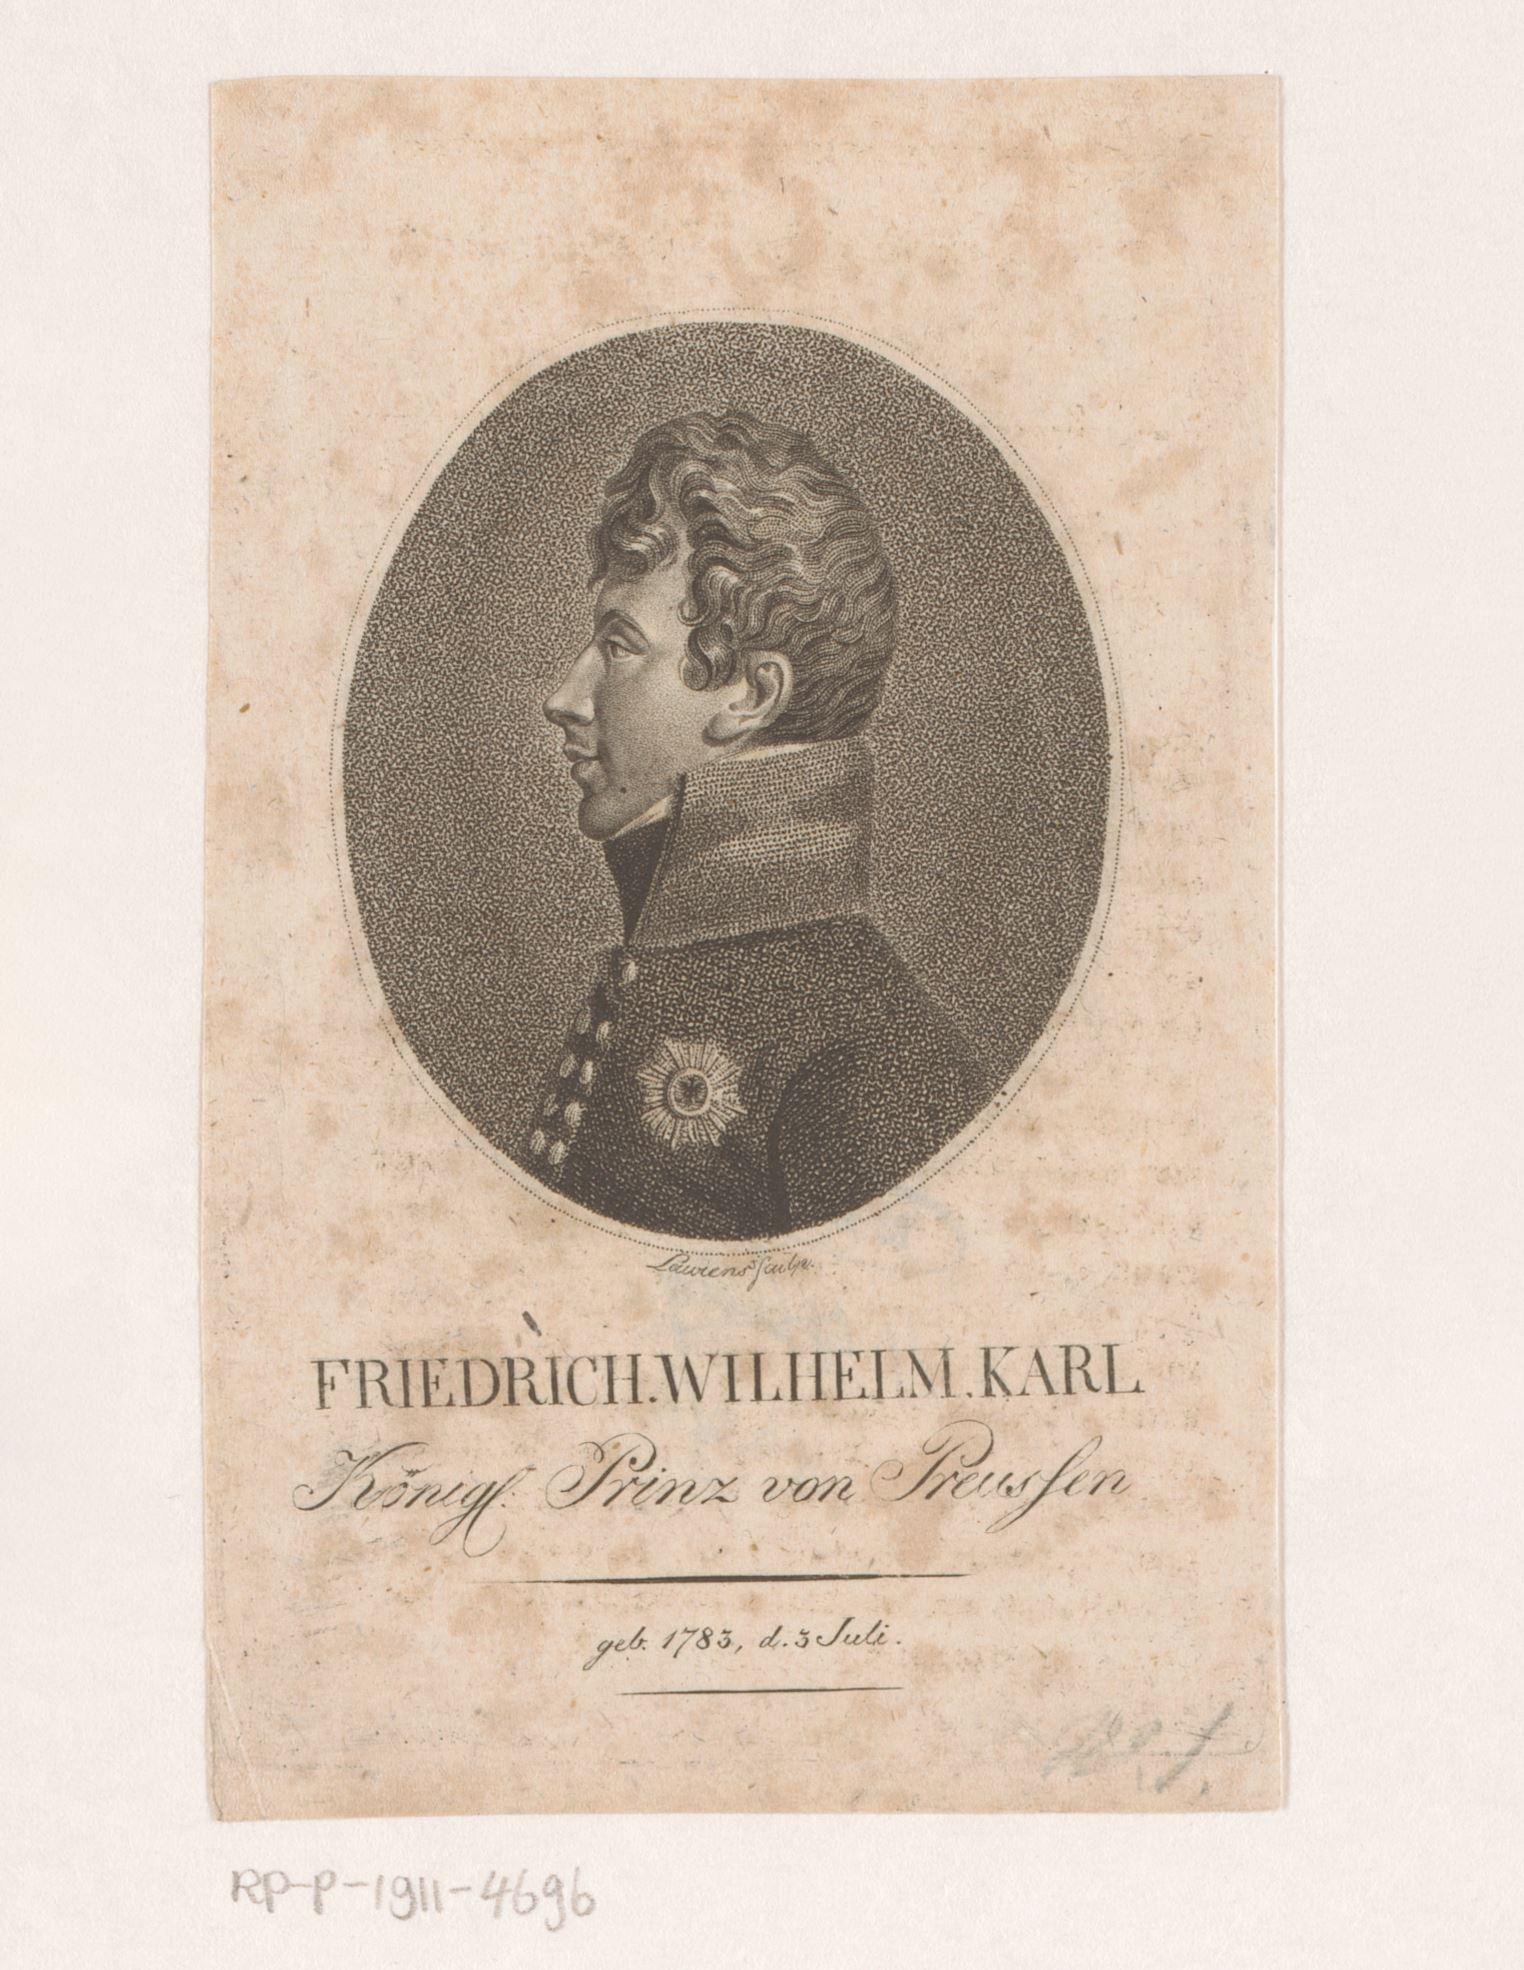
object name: print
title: Portret van Willem van Pruisen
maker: johann daniel laurenz (ii)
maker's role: draughtsman, print maker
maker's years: 1770-1832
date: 1793-1832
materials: paper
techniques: stippling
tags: berlin, commander-in-chief, general, marshal, historical persons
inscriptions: collector's mark: Lugt 2228